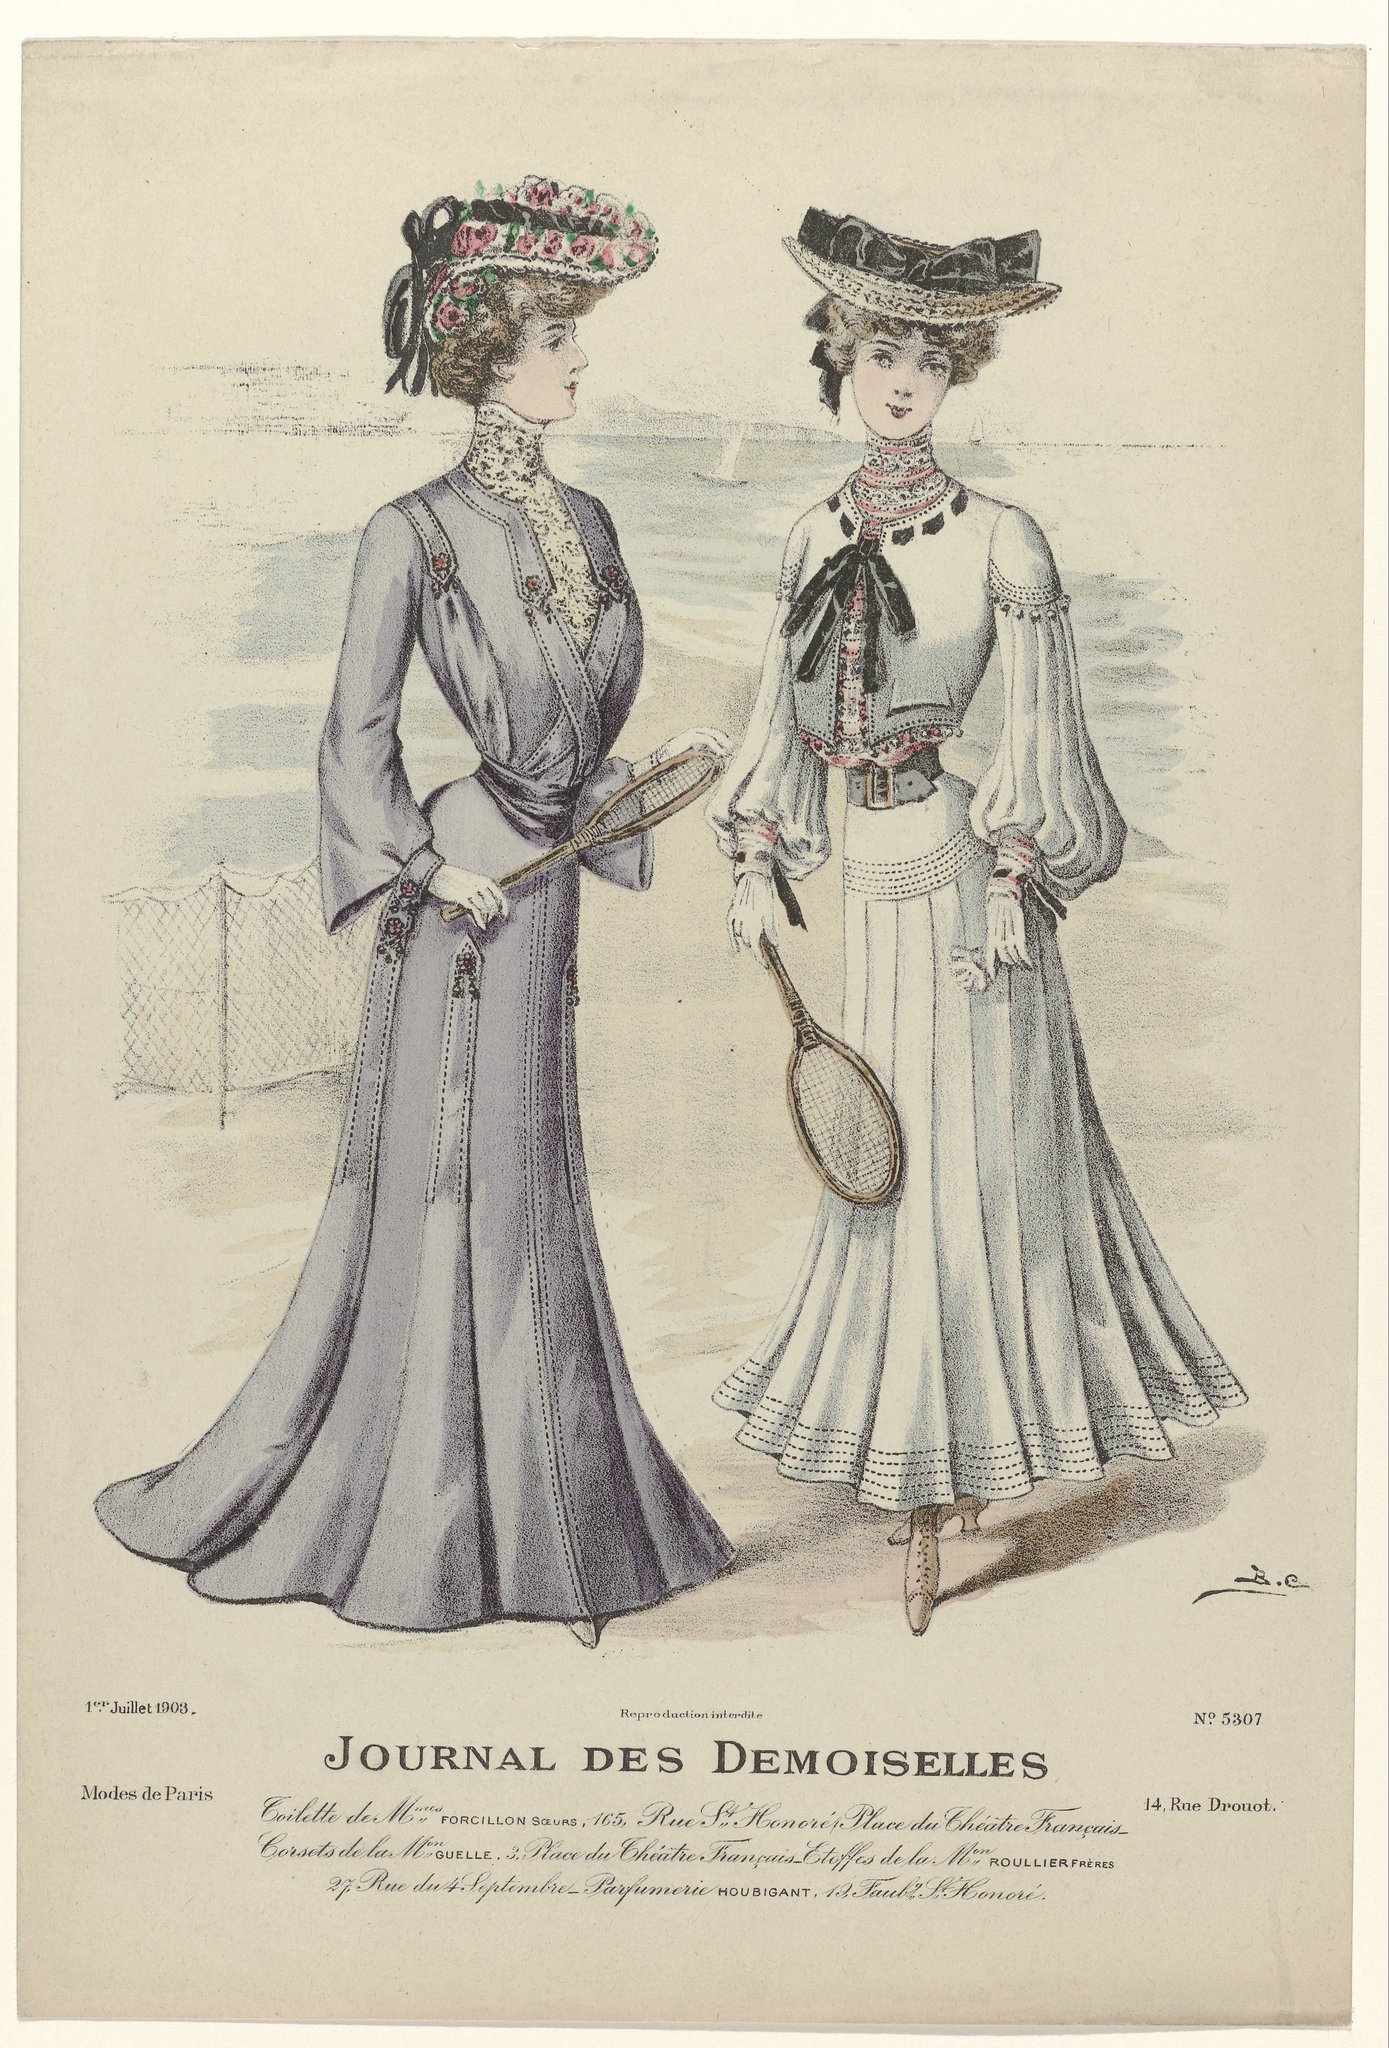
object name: fashion print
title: Journal des Demoiselles, 1 juillet 1903, No. 5307 : Toilette de Mmes Forcillon Soeurs (...)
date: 1903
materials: paper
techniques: hand coloring, lithograph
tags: clothing for the upper part of the body (+ women's clothes), 'jeu de volant', badminton (+ out of doors (sports, games, etc.)), fashion plates, head-gear: hat (+ women's clothes), skirt (+ women's clothes), gloves, mittens, etc. (+ women's clothes), dress, gown (+ women's clothes), sea (seascape), neck-gear ~ clothing (+ women's clothes), belt, girdle, waistband (+ women's clothes)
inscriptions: title: ‘Journal des Demoiselles’, caption: ‘Toilette de M.mes Forcillon Soeurs, 165, Rue S.t Honoré Place du Théâtre Français_ Corsets de la M.on Guelle,3 , Place du Théâtre Français_ Etoffes de la M.on Roullier Frères 27, Rue du 4, Septembre_ Parfumerie Houbigant, 12 Faub.g S.t Honoré.’, address: ‘Modes de Paris / 14, Rue Drouot.’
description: Twee dames met tennisracket in de hand. Japonnen van van Forcillon Soeurs. Korsetten van de firma Guelle. Stoffen van de firma Roullier Frères. Parfumerie van Houbigant. Prent uit het modetijdschrift Journal des Demoiselles (1833 -1922).